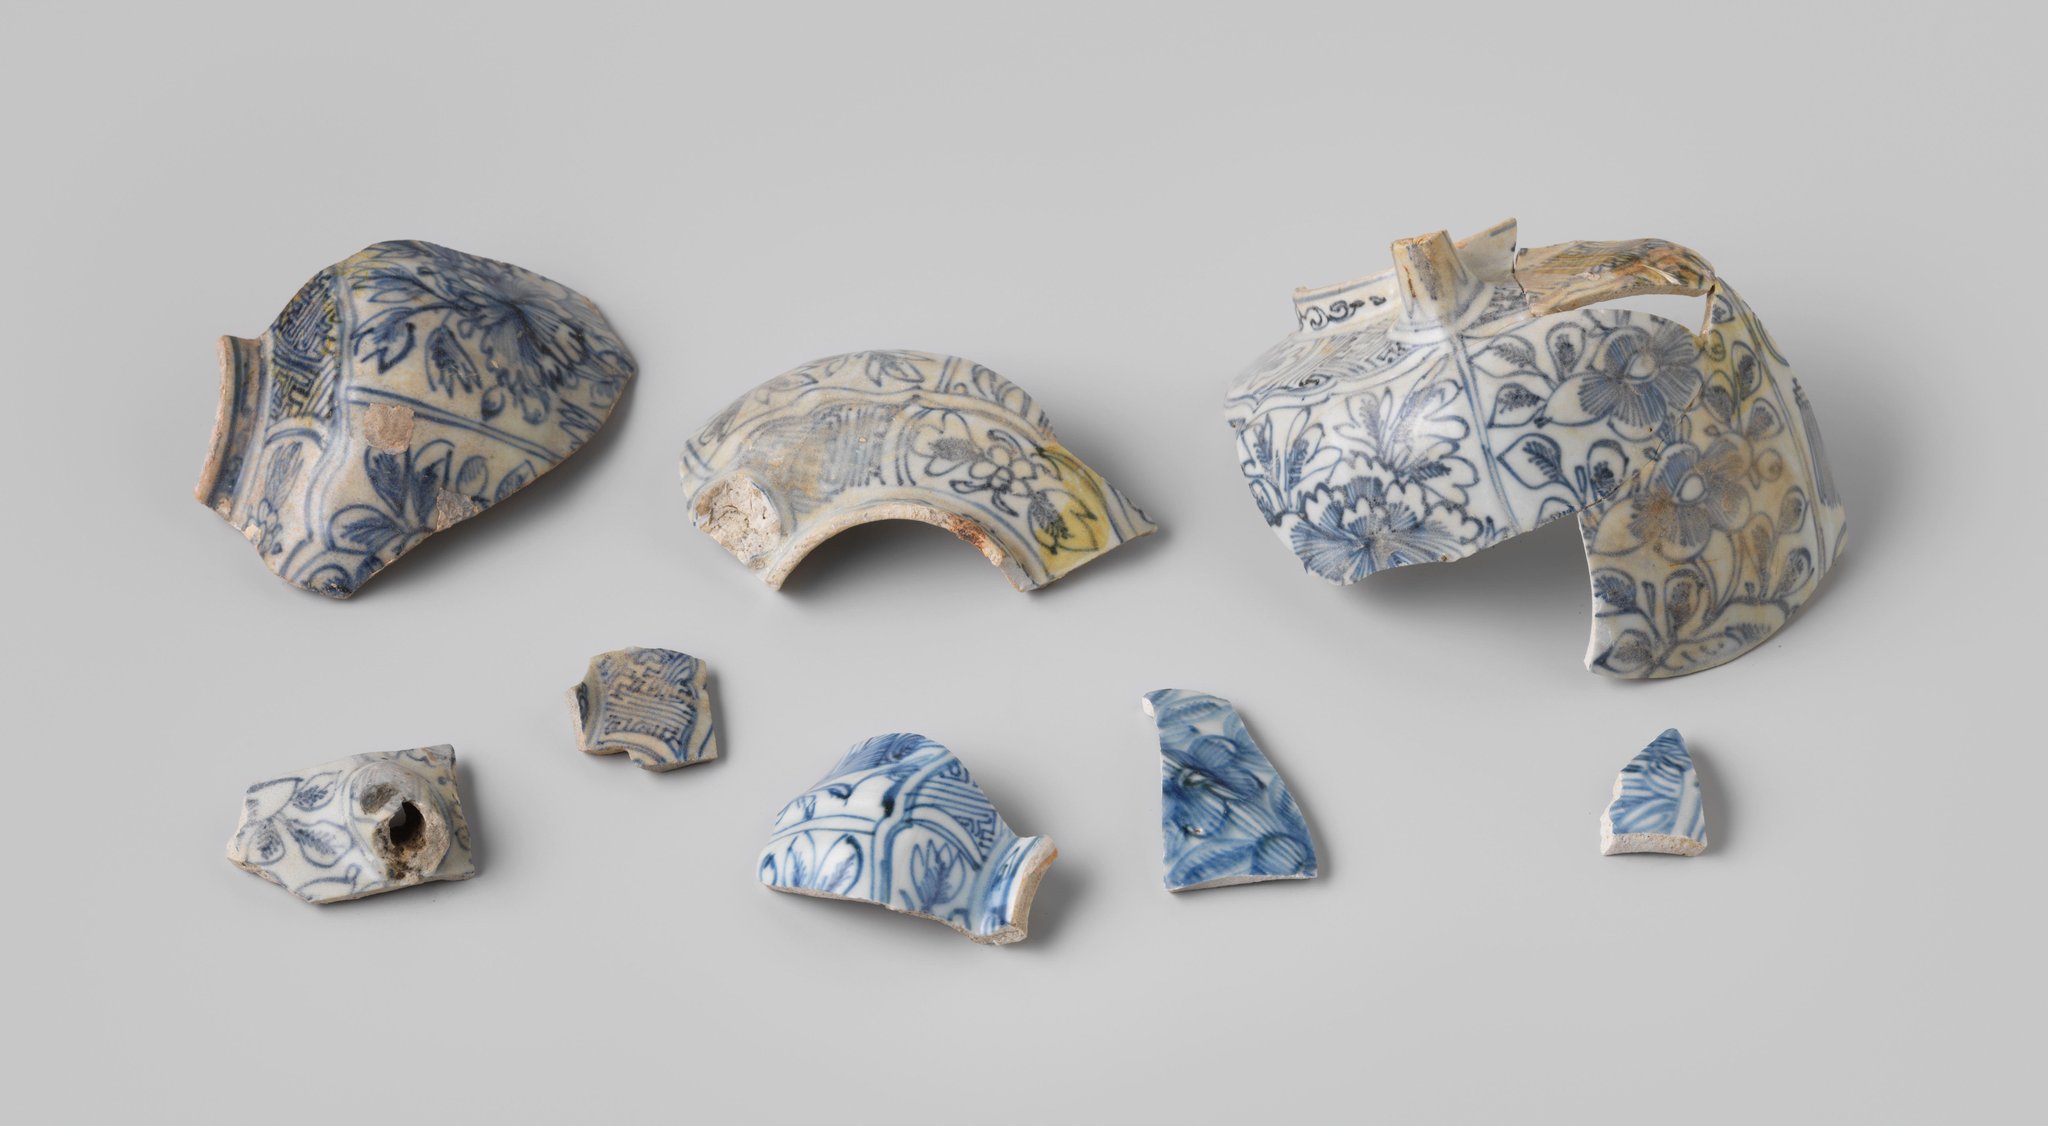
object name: sherd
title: Scherven uit V.O.C.-schip de 'Witte Leeuw'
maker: Anonymous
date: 1613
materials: bone china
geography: jingdezhen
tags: verenigde oostindische compagnie, sint-helena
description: Scherven kraakporselein uit V.O.C.-schip de 'Witte Leeuw'. Zak met scherven van wijnpotten. Eén bestaande uit vier aan elkaar gelijmde fragmenten.